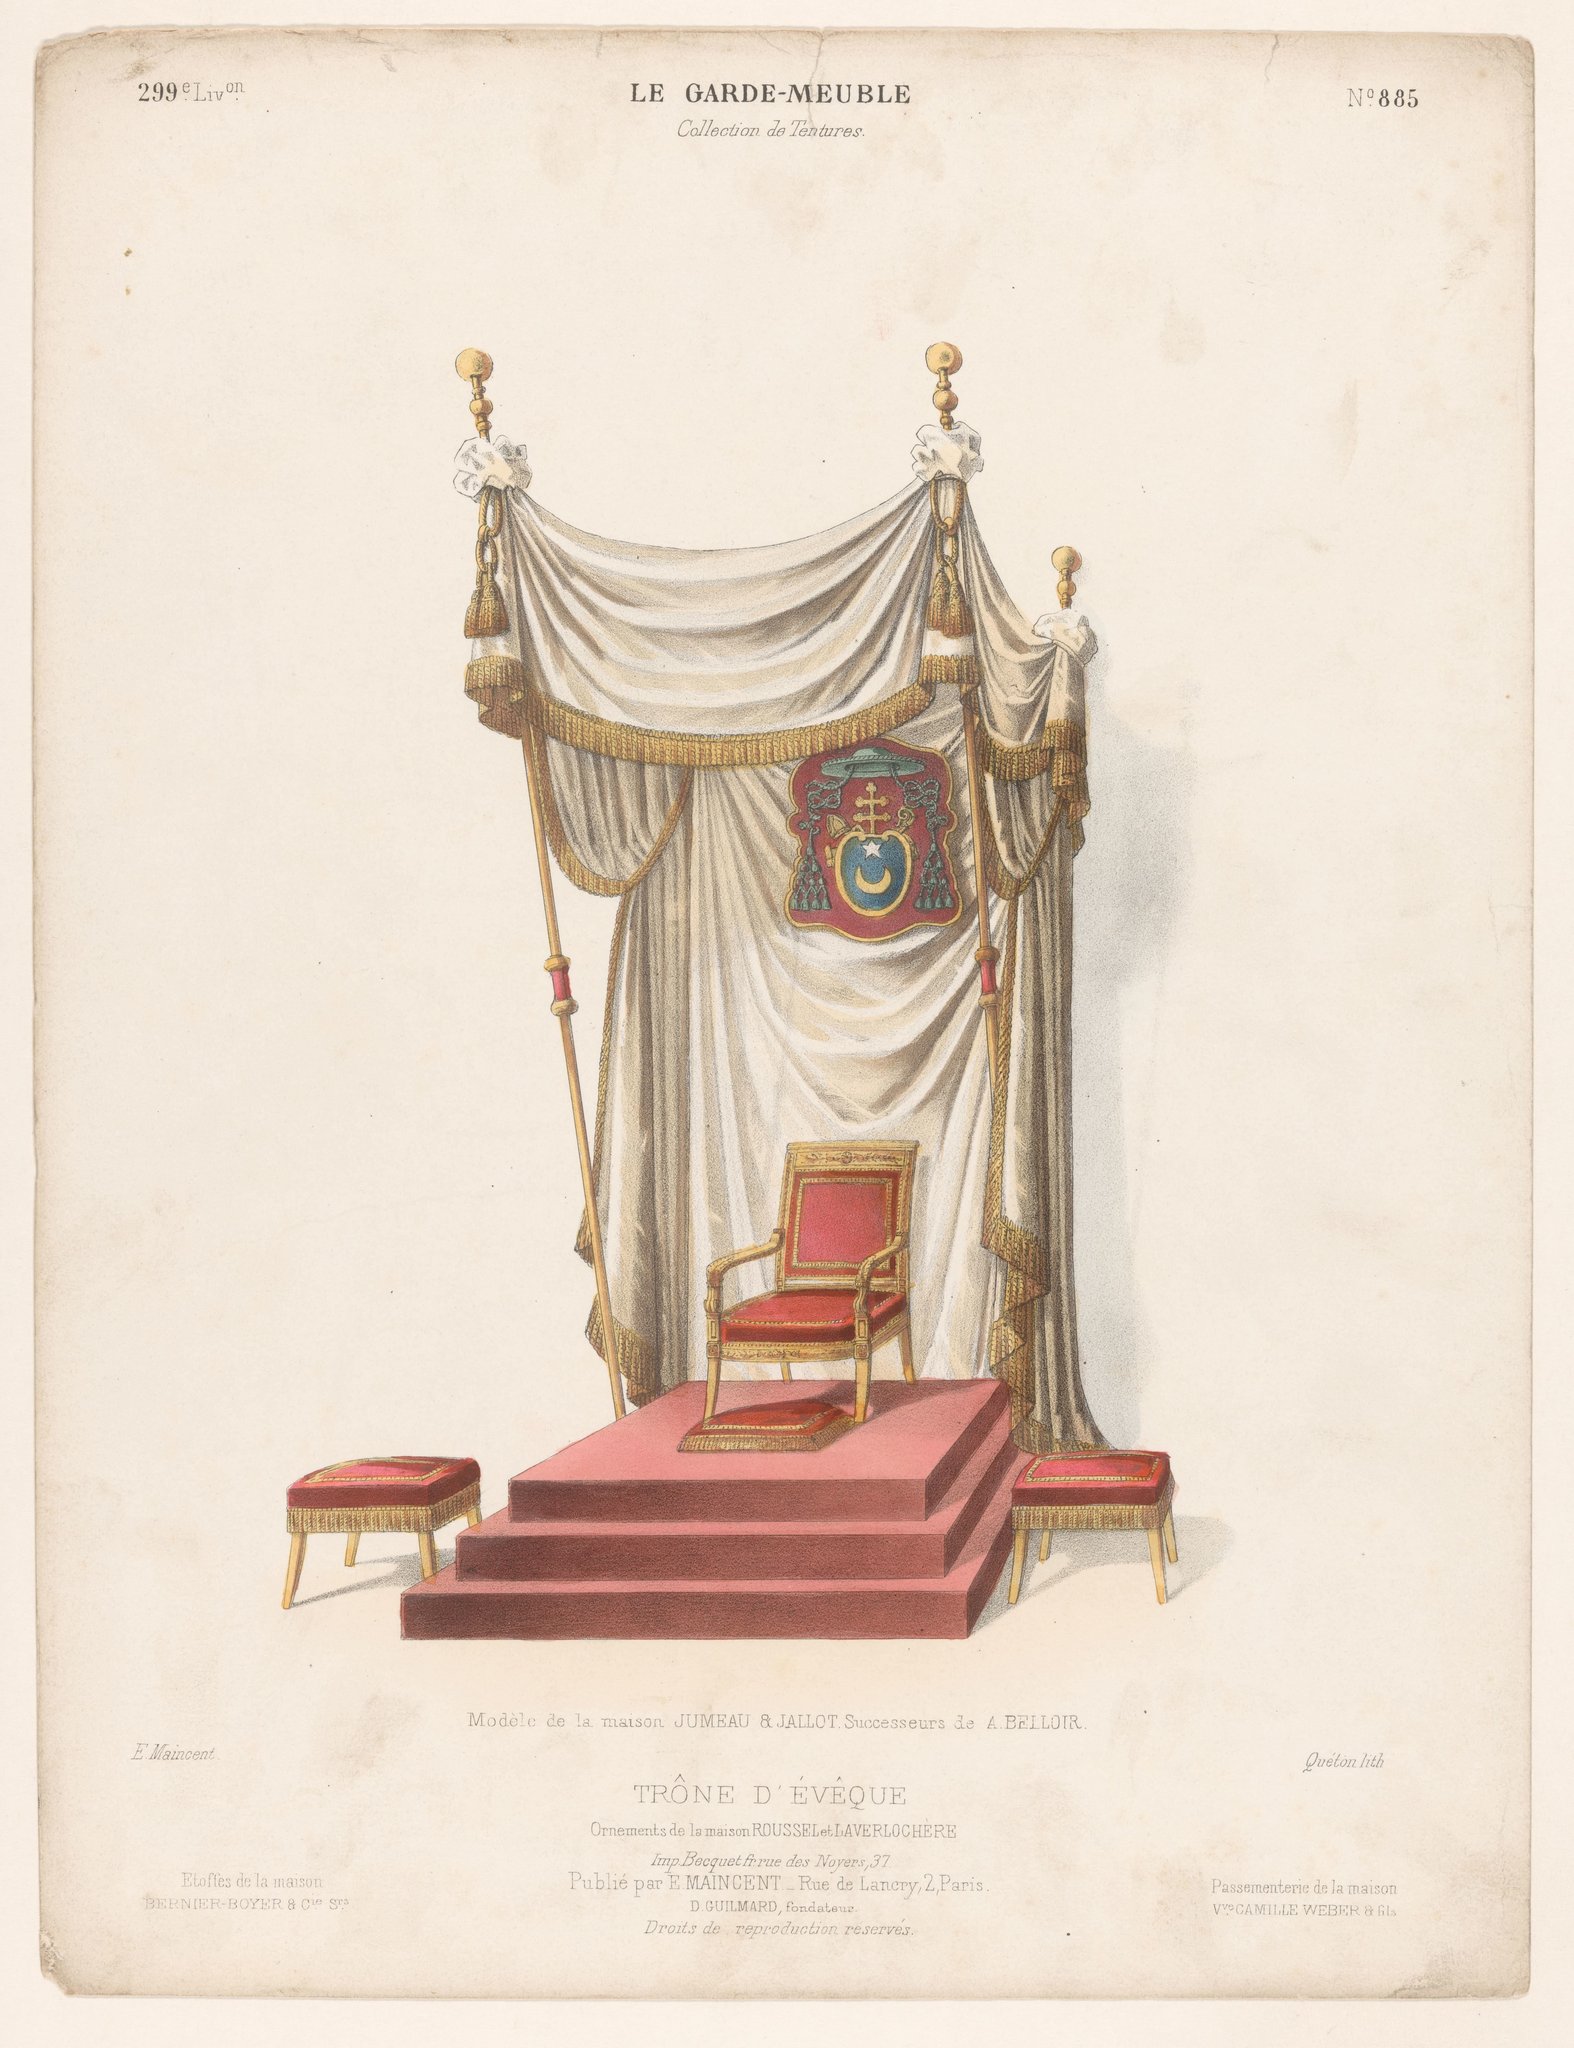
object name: print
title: Bisschopszetel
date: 1885-1895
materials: paper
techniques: hand coloring, lithograph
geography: paris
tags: bishop's throne, hangings and drapery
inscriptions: : ‘Droits de reproduction réservés.’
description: Bisschopszetel met baldakijn, wapenschild en draperieën. Prent uit 299e Livraison.